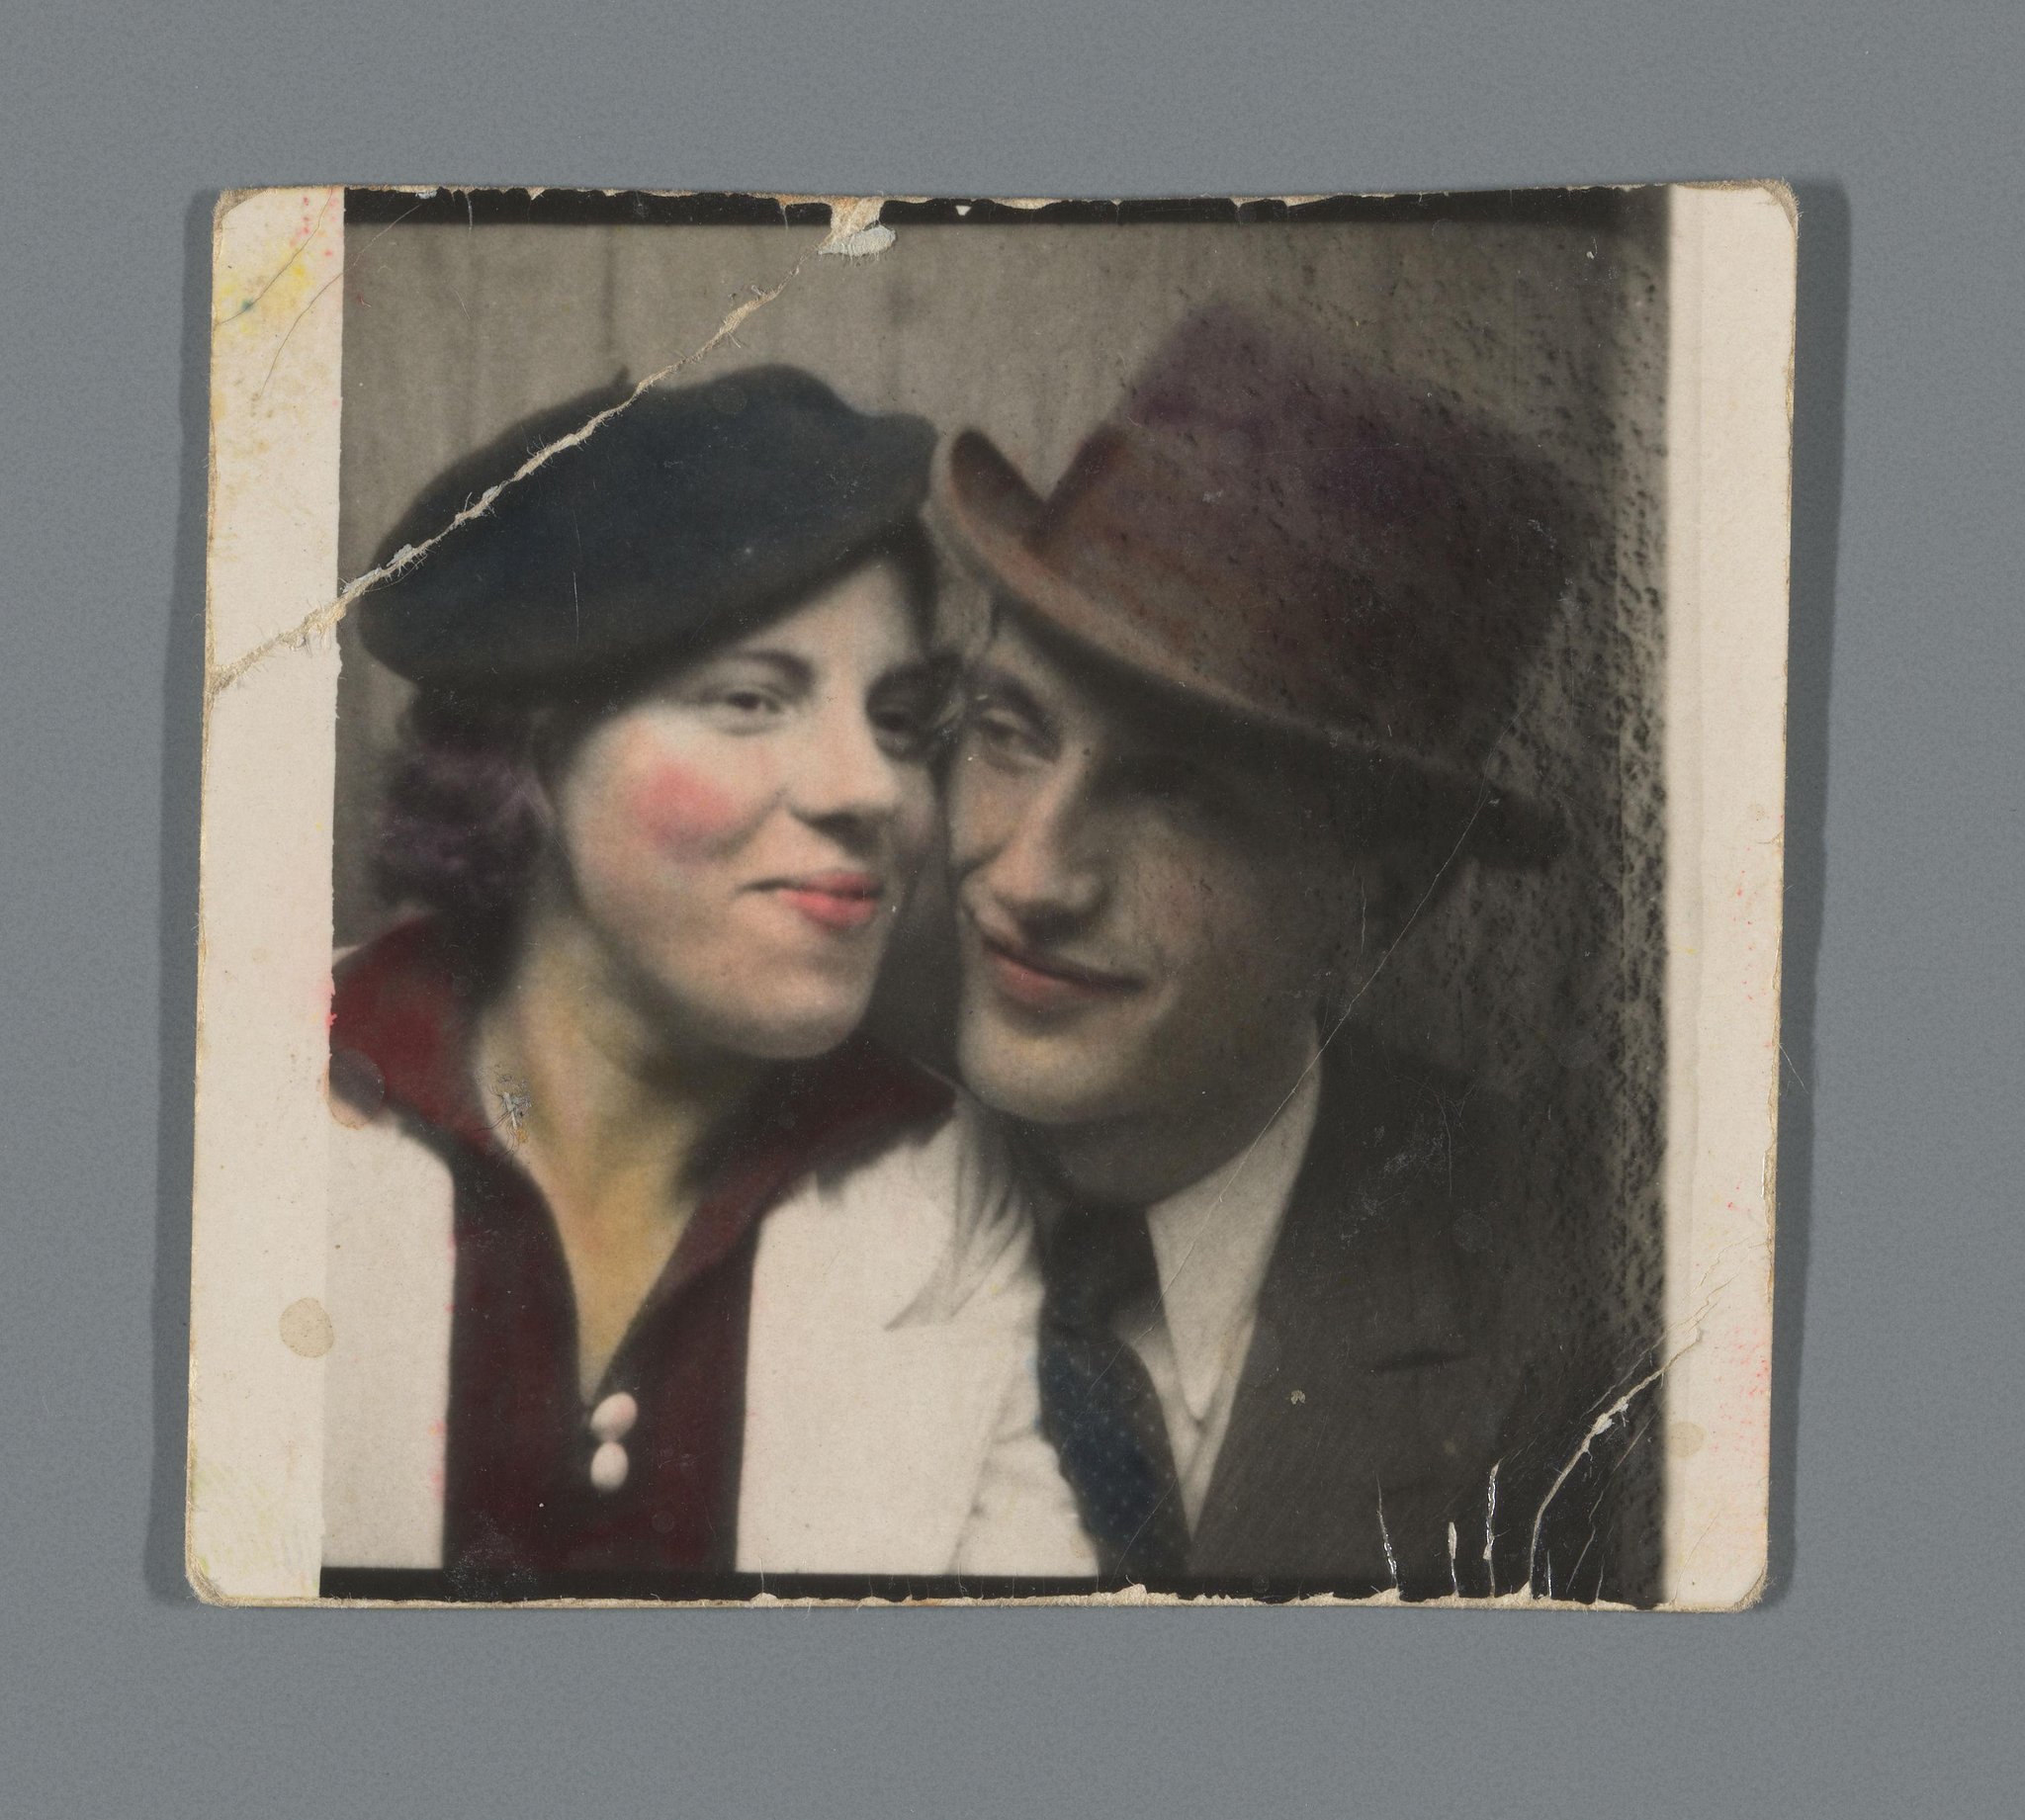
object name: photograph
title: Portret van een vrouw en een man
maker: Anonymous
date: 1935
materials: paper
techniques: gelatin silver print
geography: united states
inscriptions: inscription: ‘1935’